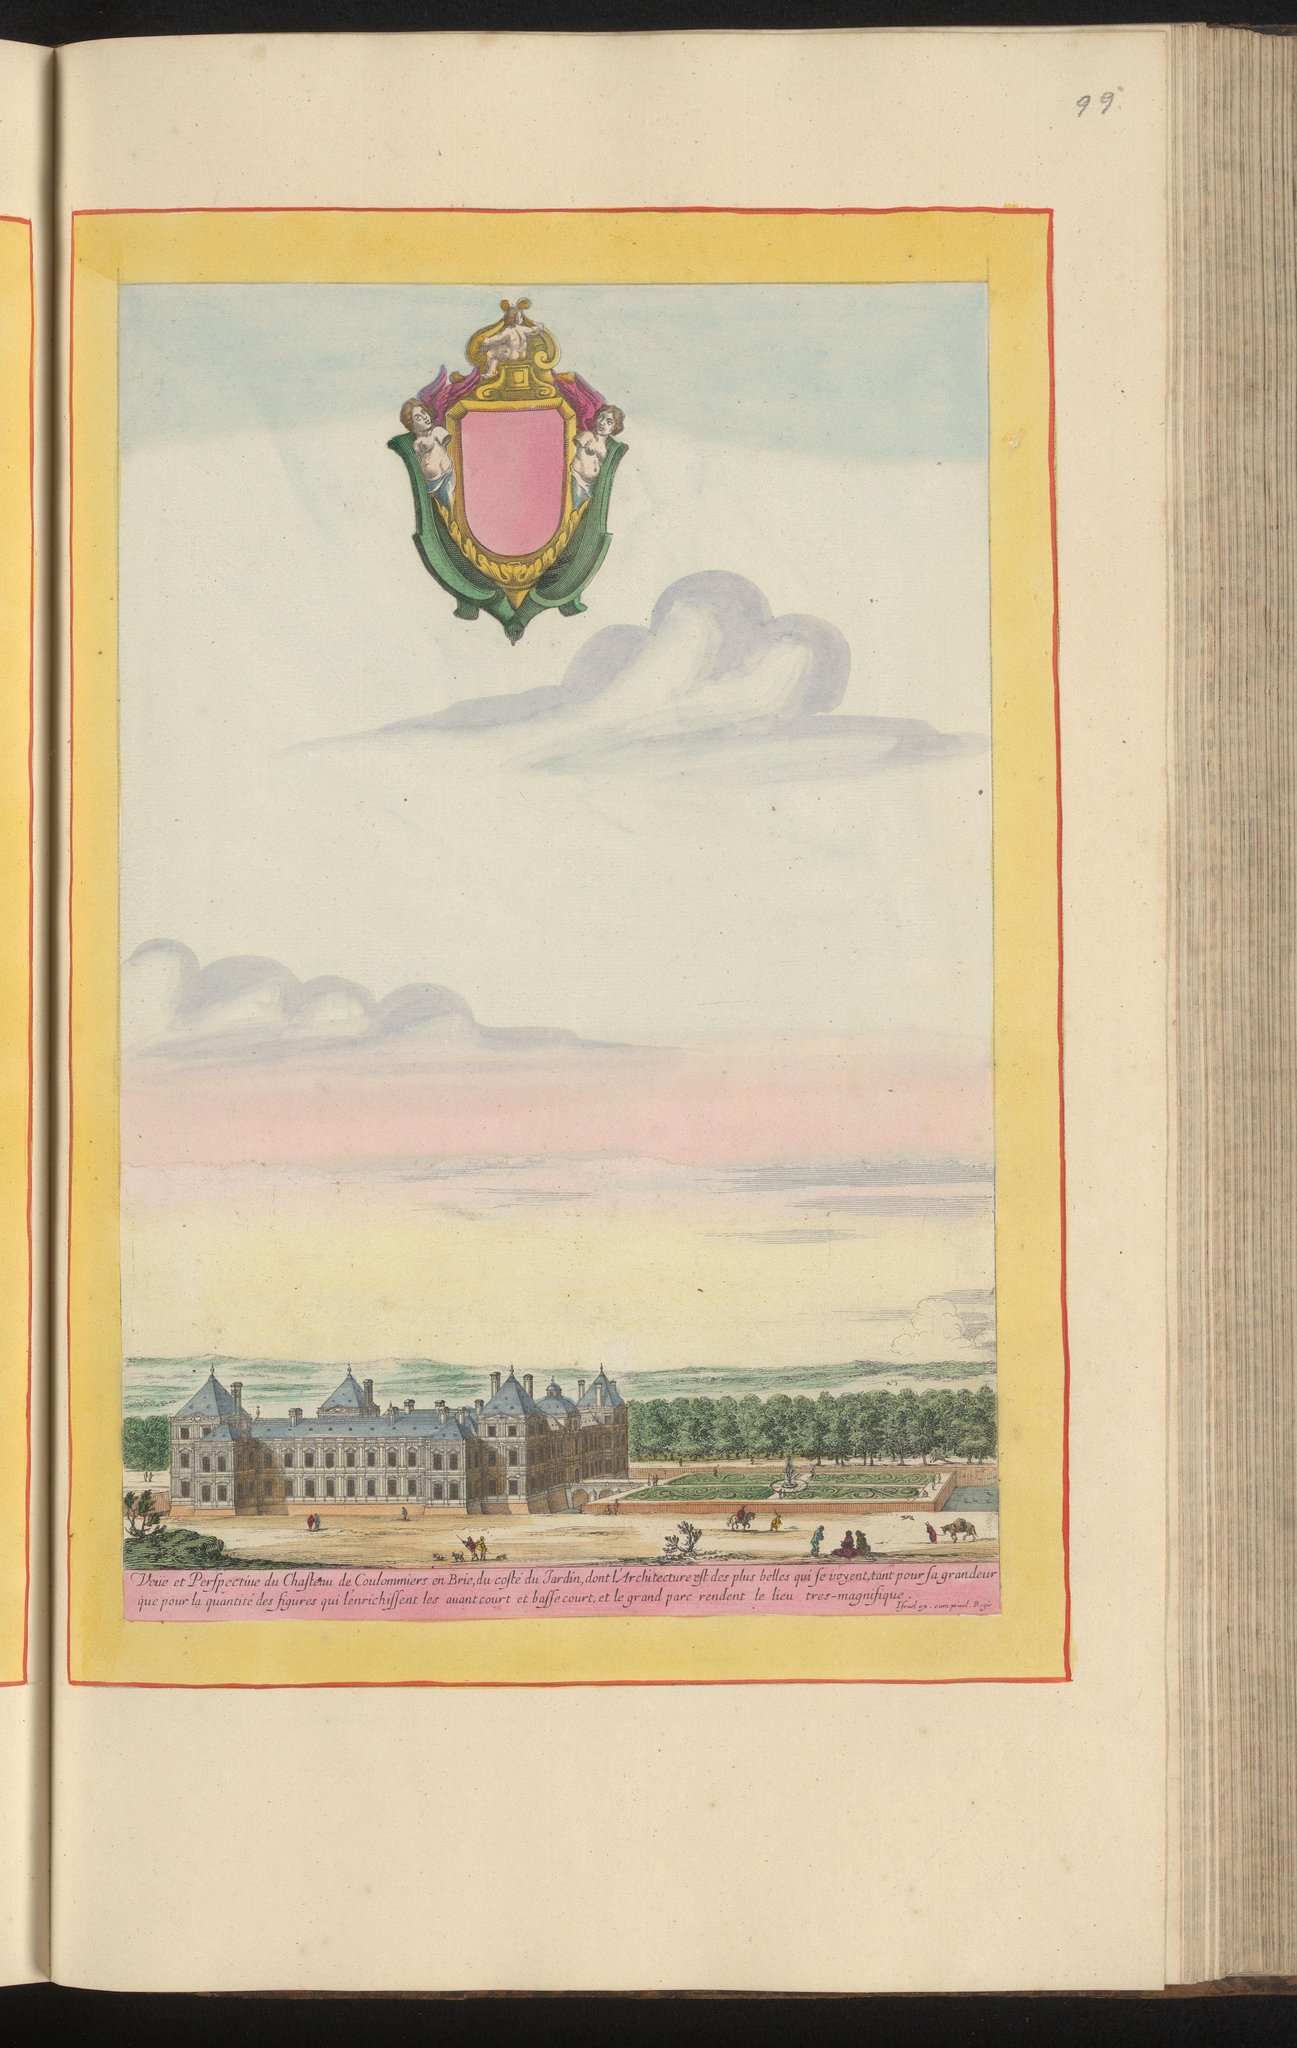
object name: print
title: Gezichten op diverse kastelen en landschappen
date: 1651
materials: paper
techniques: etching, hand coloring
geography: the hague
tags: castle, landscape with tower or castle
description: Deze prent maakt deel uit van een album.